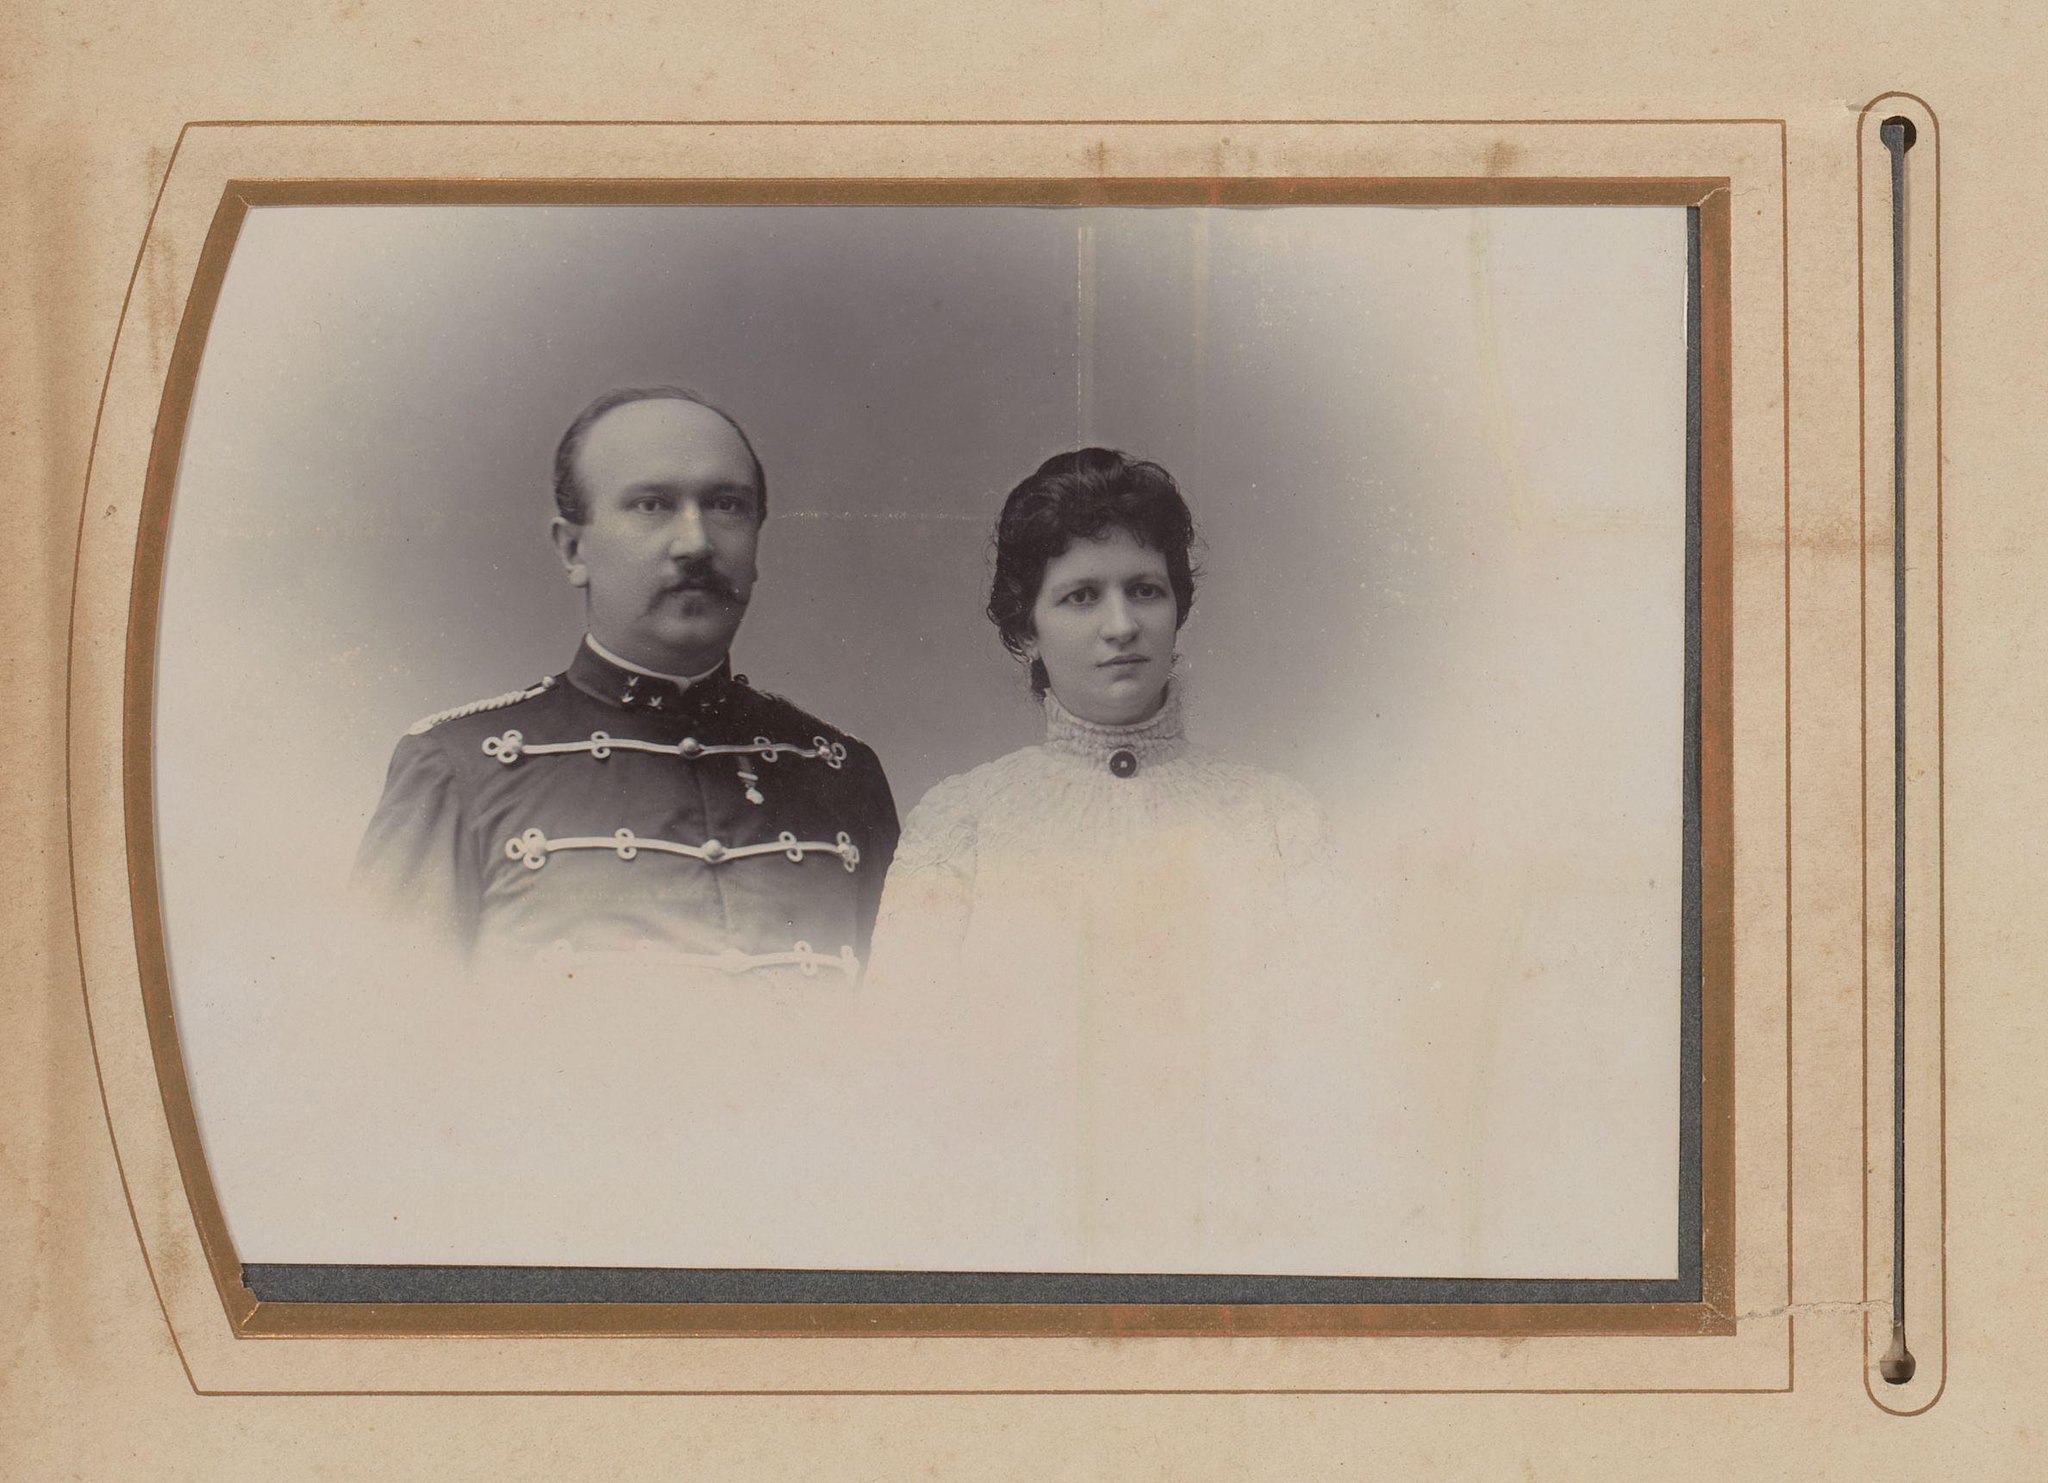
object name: album leaf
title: Portret van een man in uniform en een vrouw in witte jurk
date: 1884-1930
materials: cardboard, photographic support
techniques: gelatin silver print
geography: surabaya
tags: historical persons - bb - woman, historical persons, (military) uniforms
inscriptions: inscription: ‘Atelier/ Zalswedel/ Toendjoenan/ Soerabaia/ SOERABAIA/ 1878/ BATAVIA/ 1884’